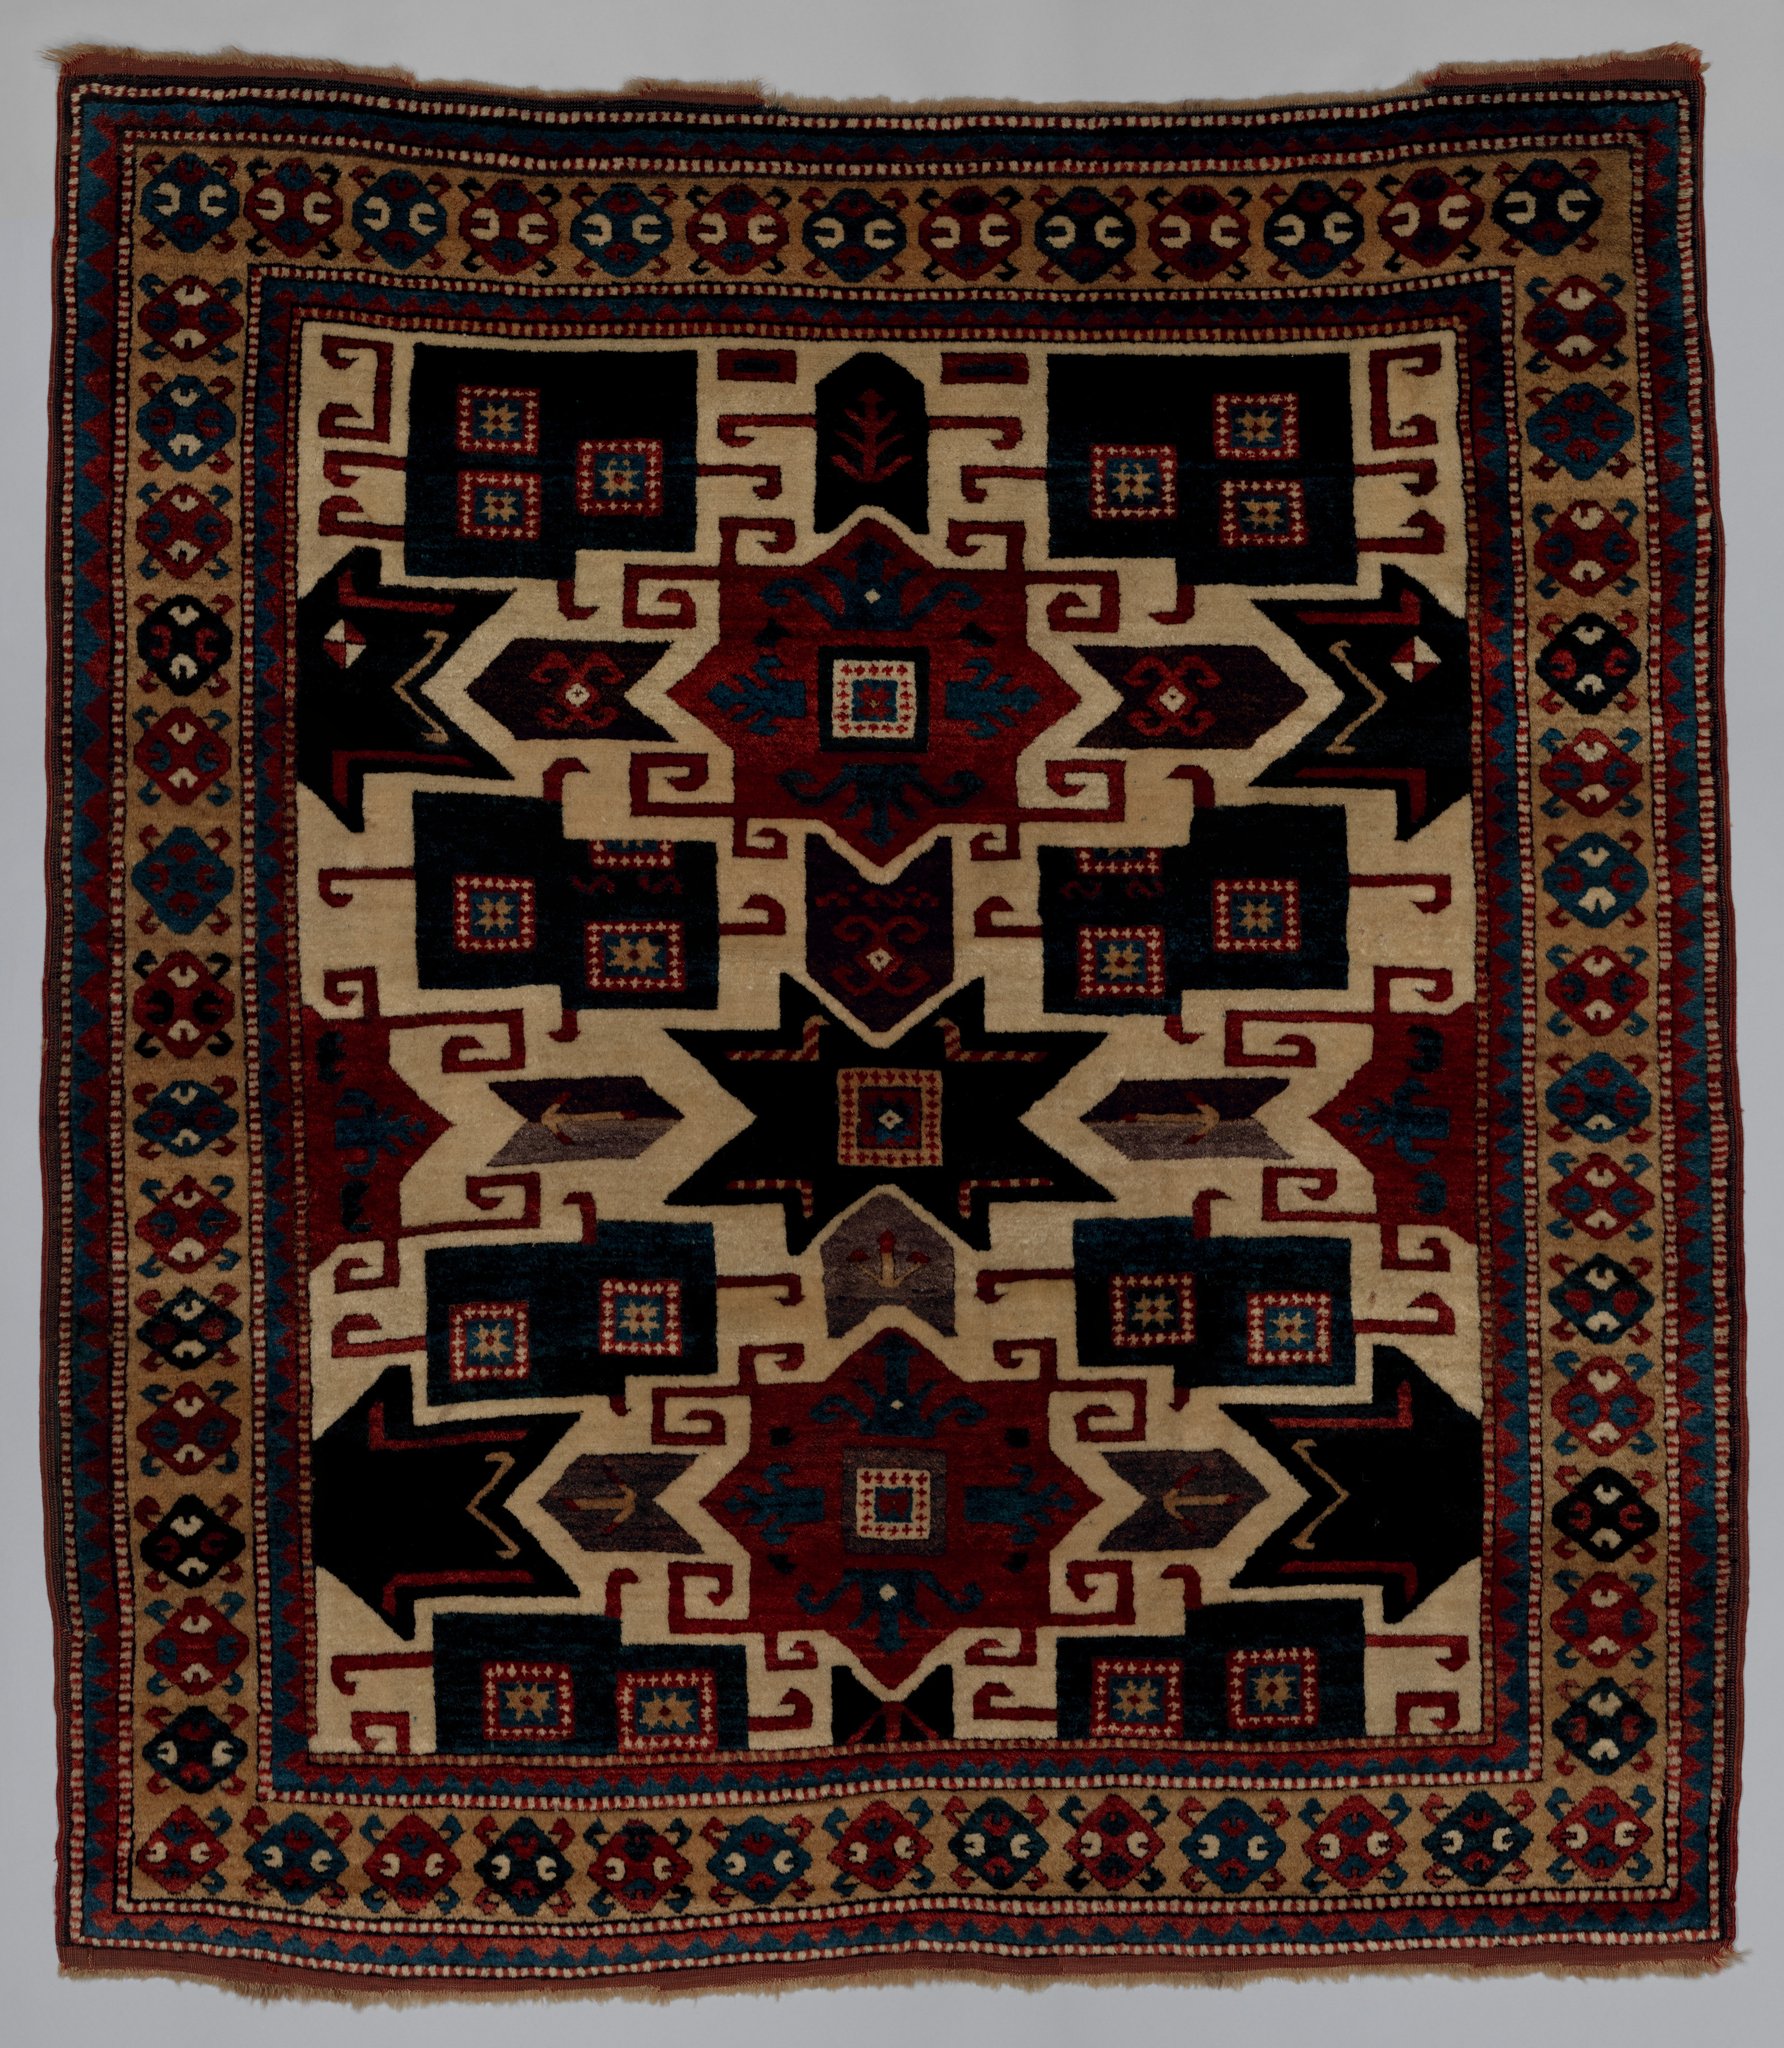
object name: carpet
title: Star Kazak Carpet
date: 1801-1833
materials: wool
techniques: pile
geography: azerbaijan